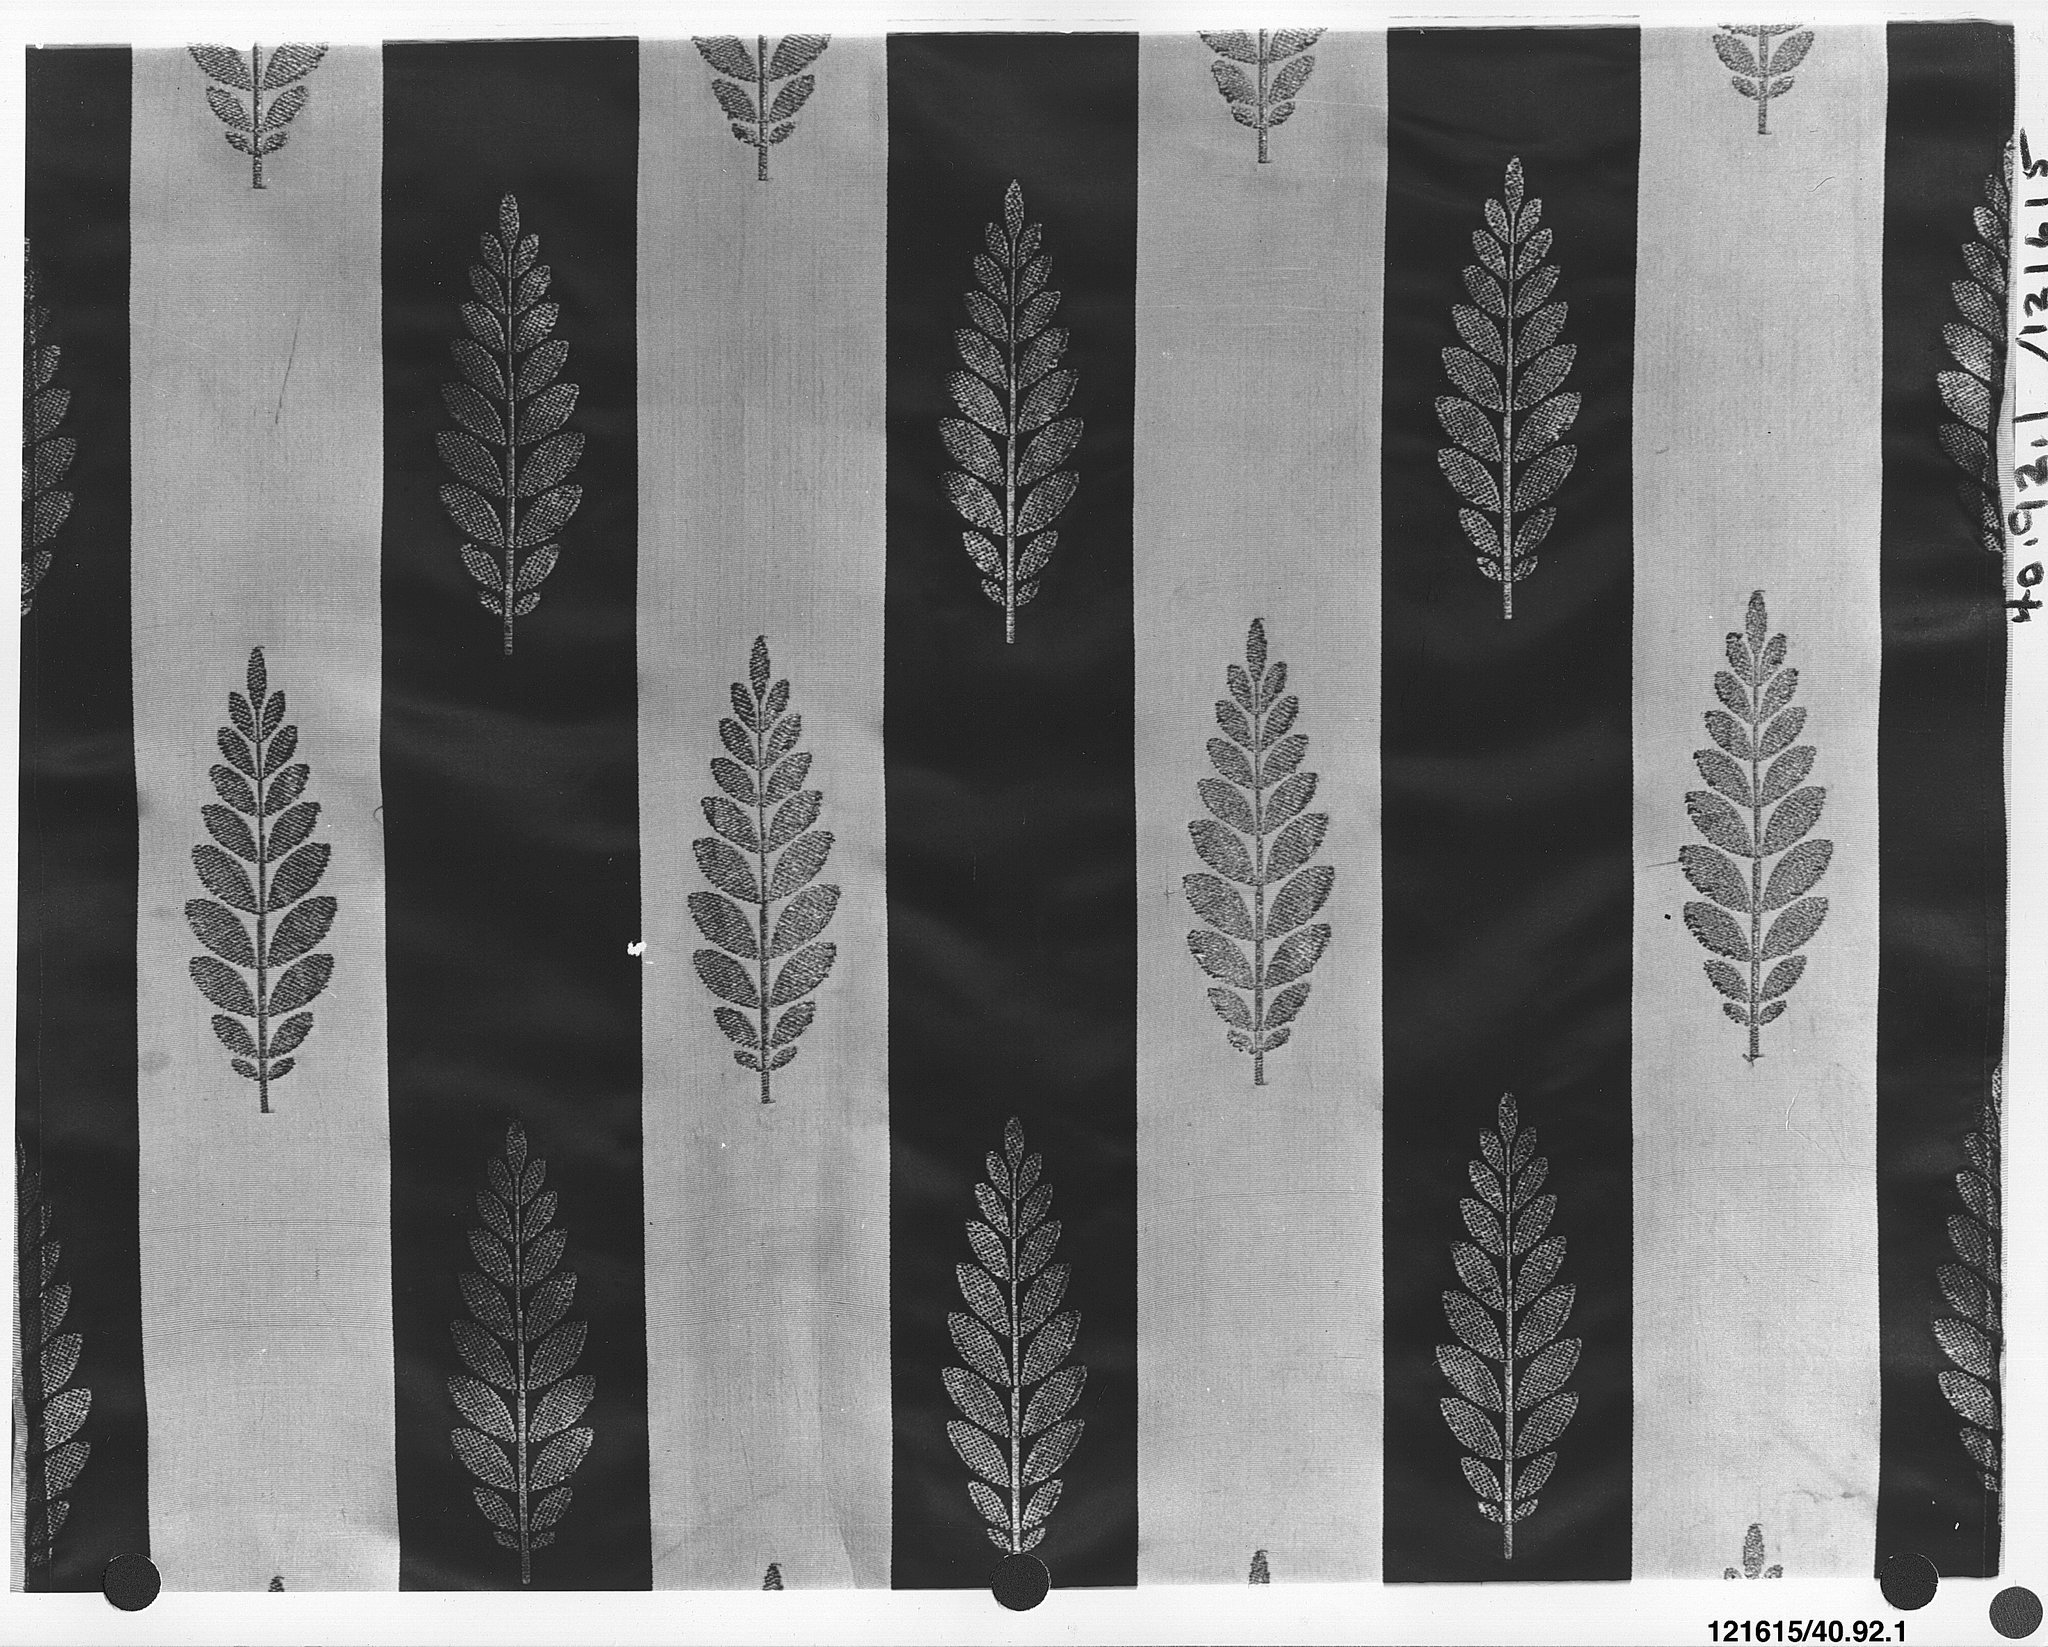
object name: piece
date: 1801-1900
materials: metal thread, silk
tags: leaves